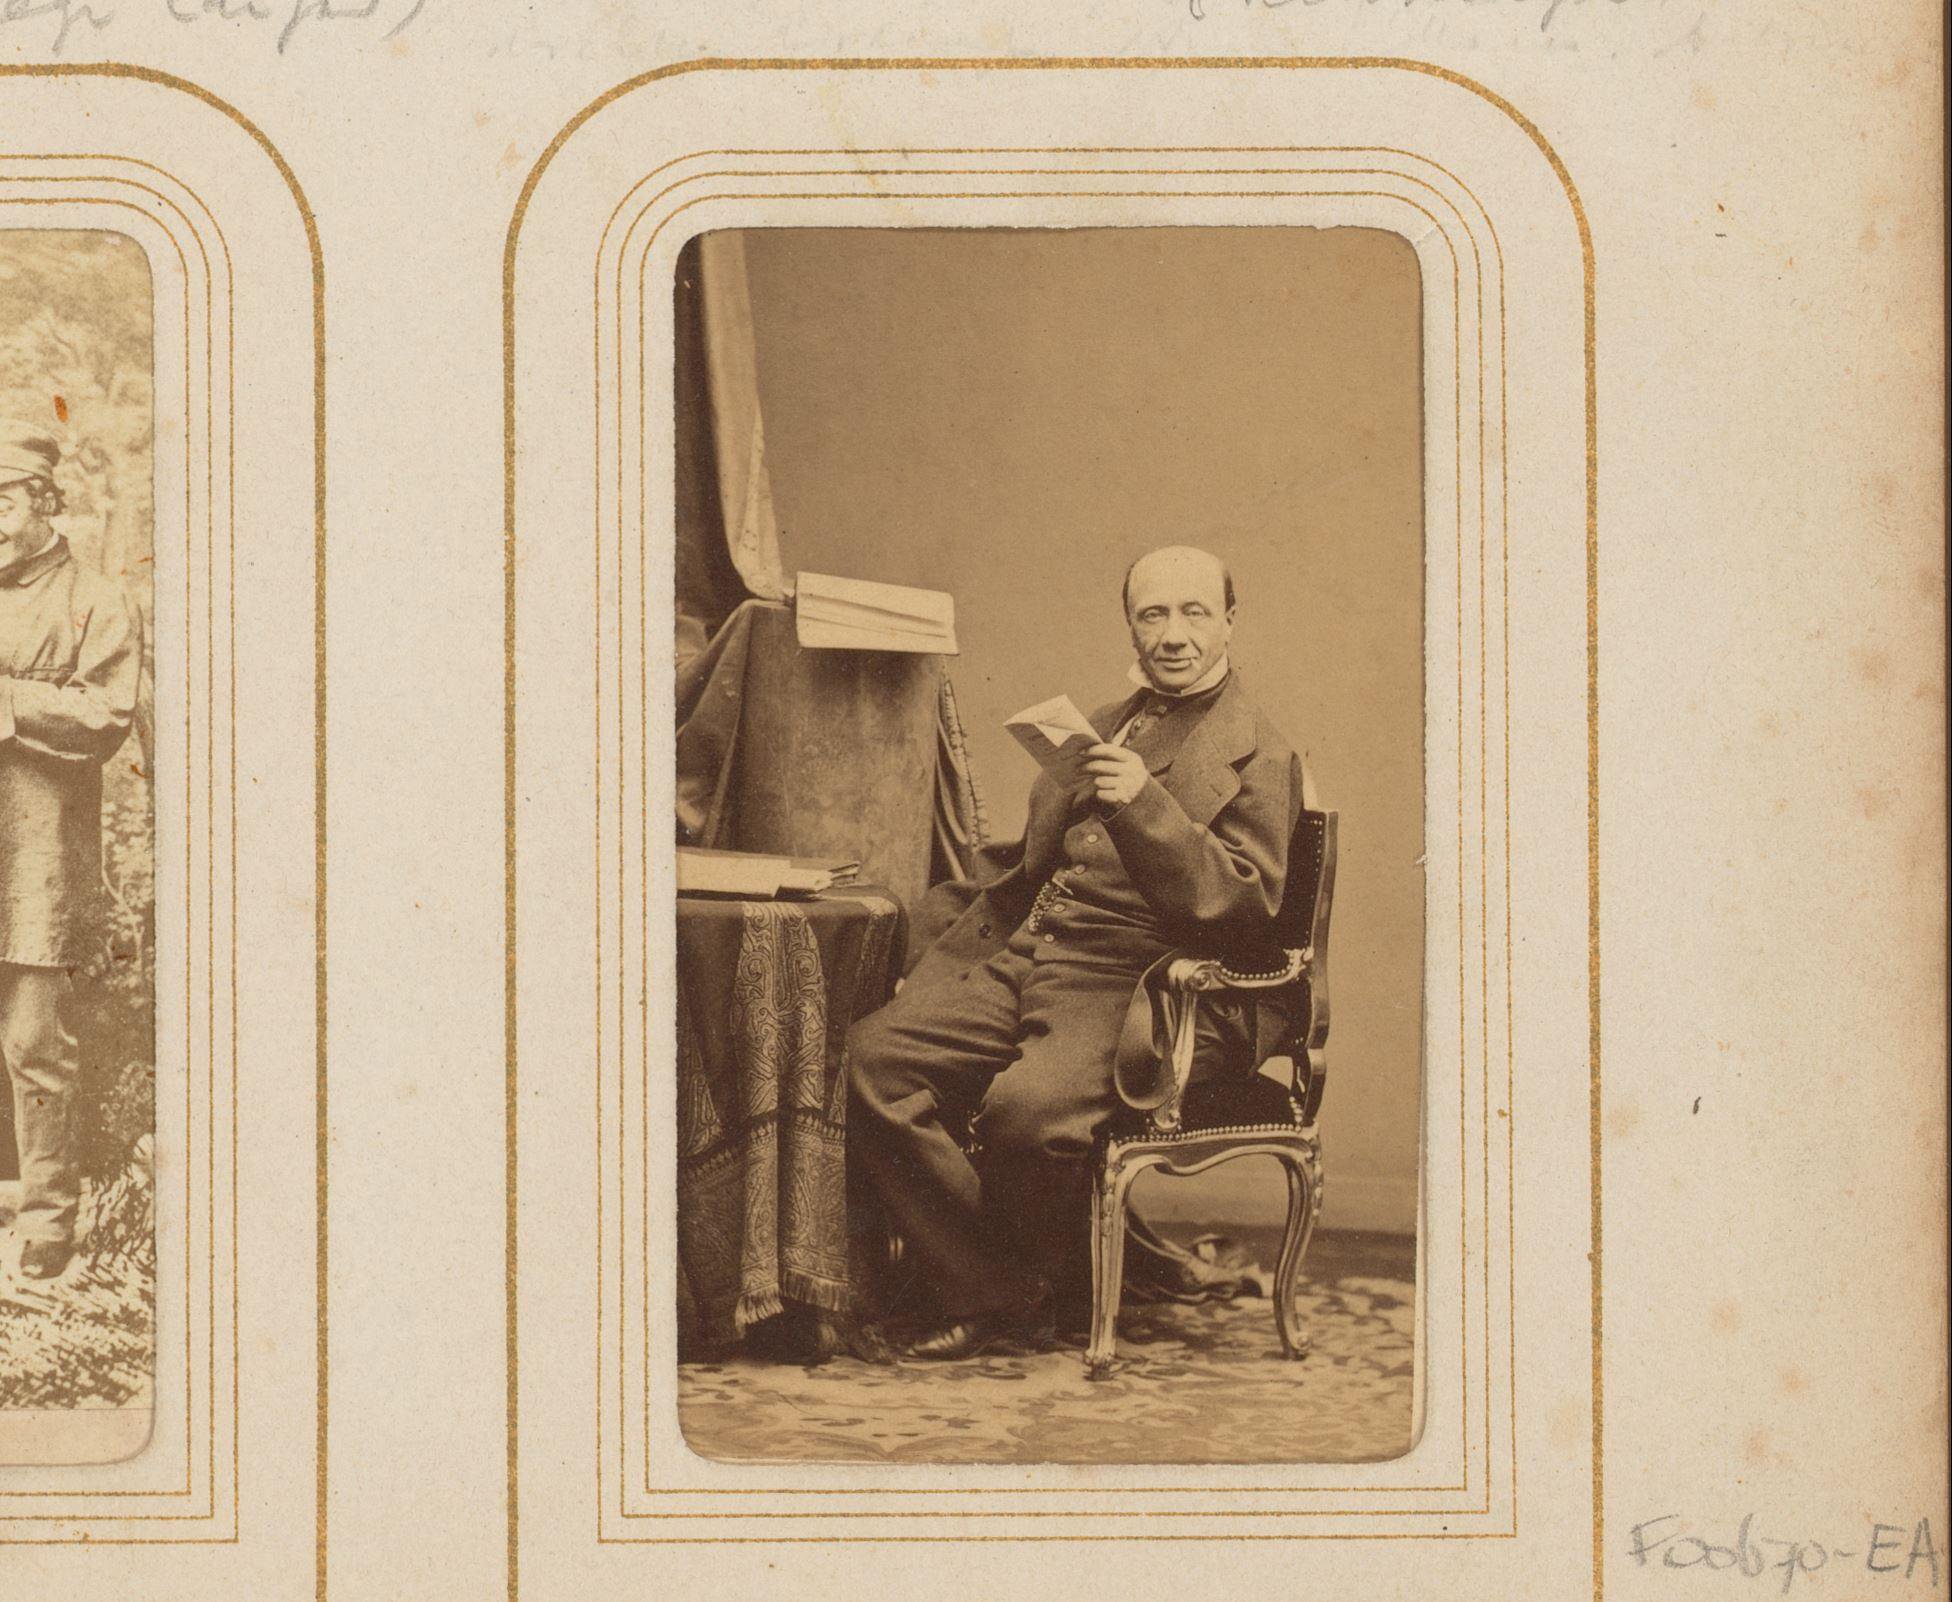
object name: album leaf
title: Portret van E. Delannoy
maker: andré-adolphe-eugène disdéri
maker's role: fotograaf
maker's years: 1819-1889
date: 1860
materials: cardboard, photographic support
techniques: albumen print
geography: paris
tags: historical persons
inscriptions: annotation: ‘Ed. Dellanoy (Disdéri)’, annotation: ‘10,-/ [...]’, annotation: ‘offert a Monsieur Cornaglio nantes ce 4 aout 1860/ Ed. Delannoy’, inscription: ‘Disderi & Cie/ photographes de S M l'empereur/ 8, Boulevard des Italiens/ Paris’